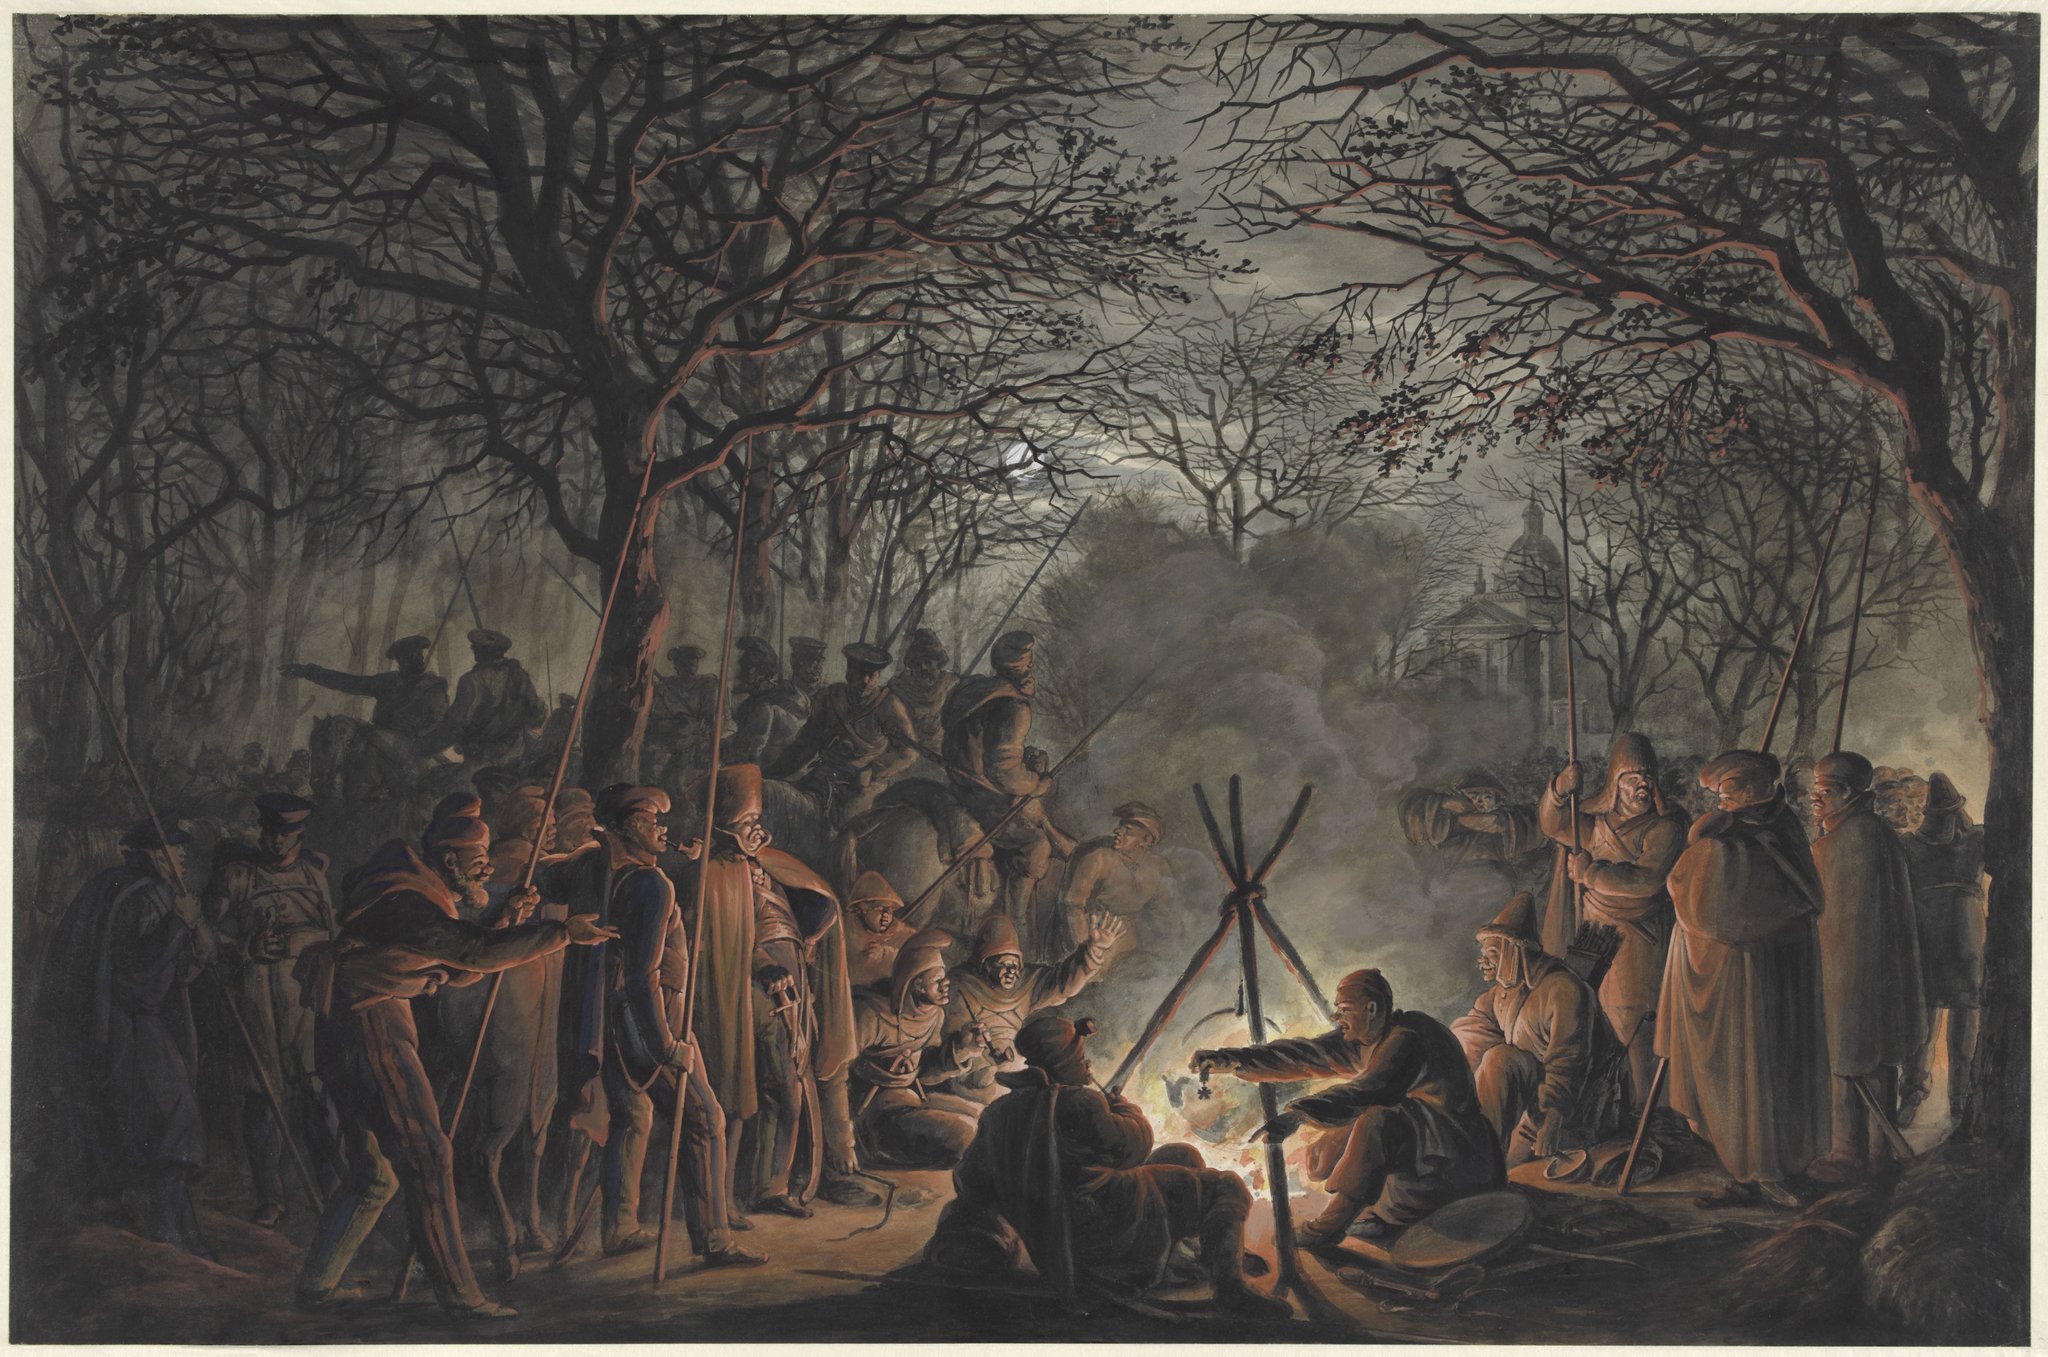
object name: drawing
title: Kamp van de kozakken buiten de Muiderpoort te Amsterdam, 1813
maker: françois joseph pfeiffer (ii)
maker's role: draughtsman, print maker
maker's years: 1778-1835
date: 1813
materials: paper, watercolor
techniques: brush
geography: netherlands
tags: (military) camp with tents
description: Kamp van de kozakken buiten de Muiderpoort te Amsterdam, 24 november 1813. Soldaten hebben zich verzameld rond een kampvuur waarboven een kookpan hangt. Op de achtergrond is door de bomen de Muiderpoort zichtbaar.